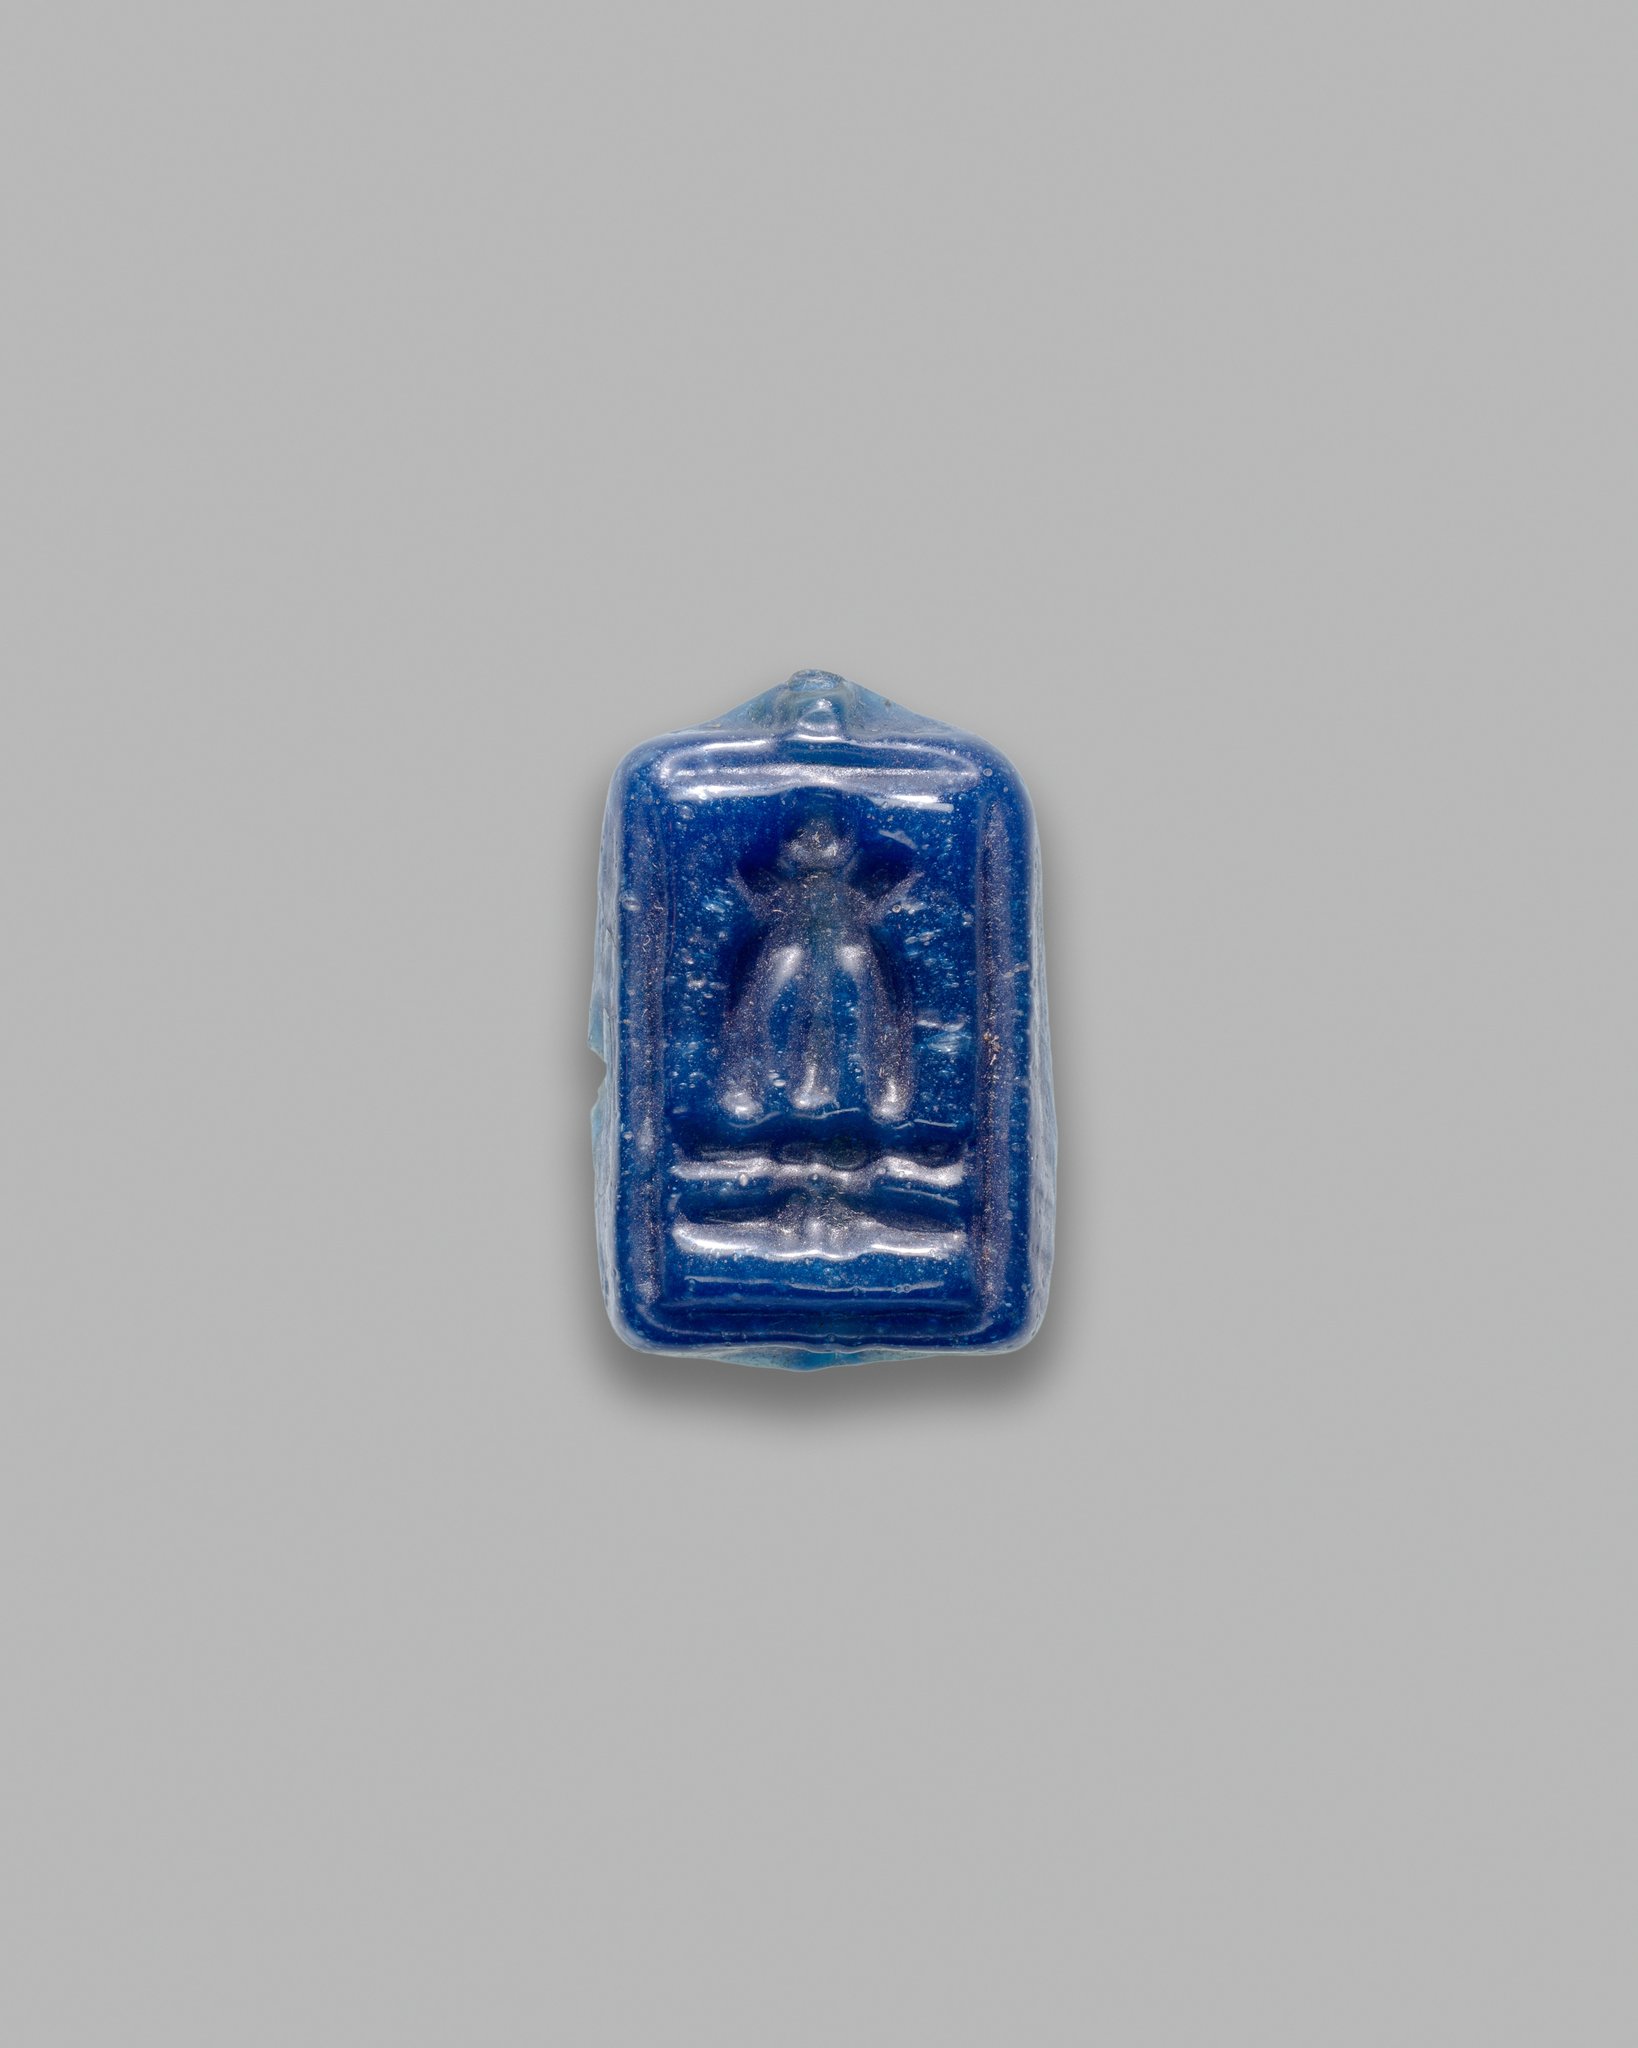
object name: foundation deposit plaque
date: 1153-1147 BCE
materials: glass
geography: egypt